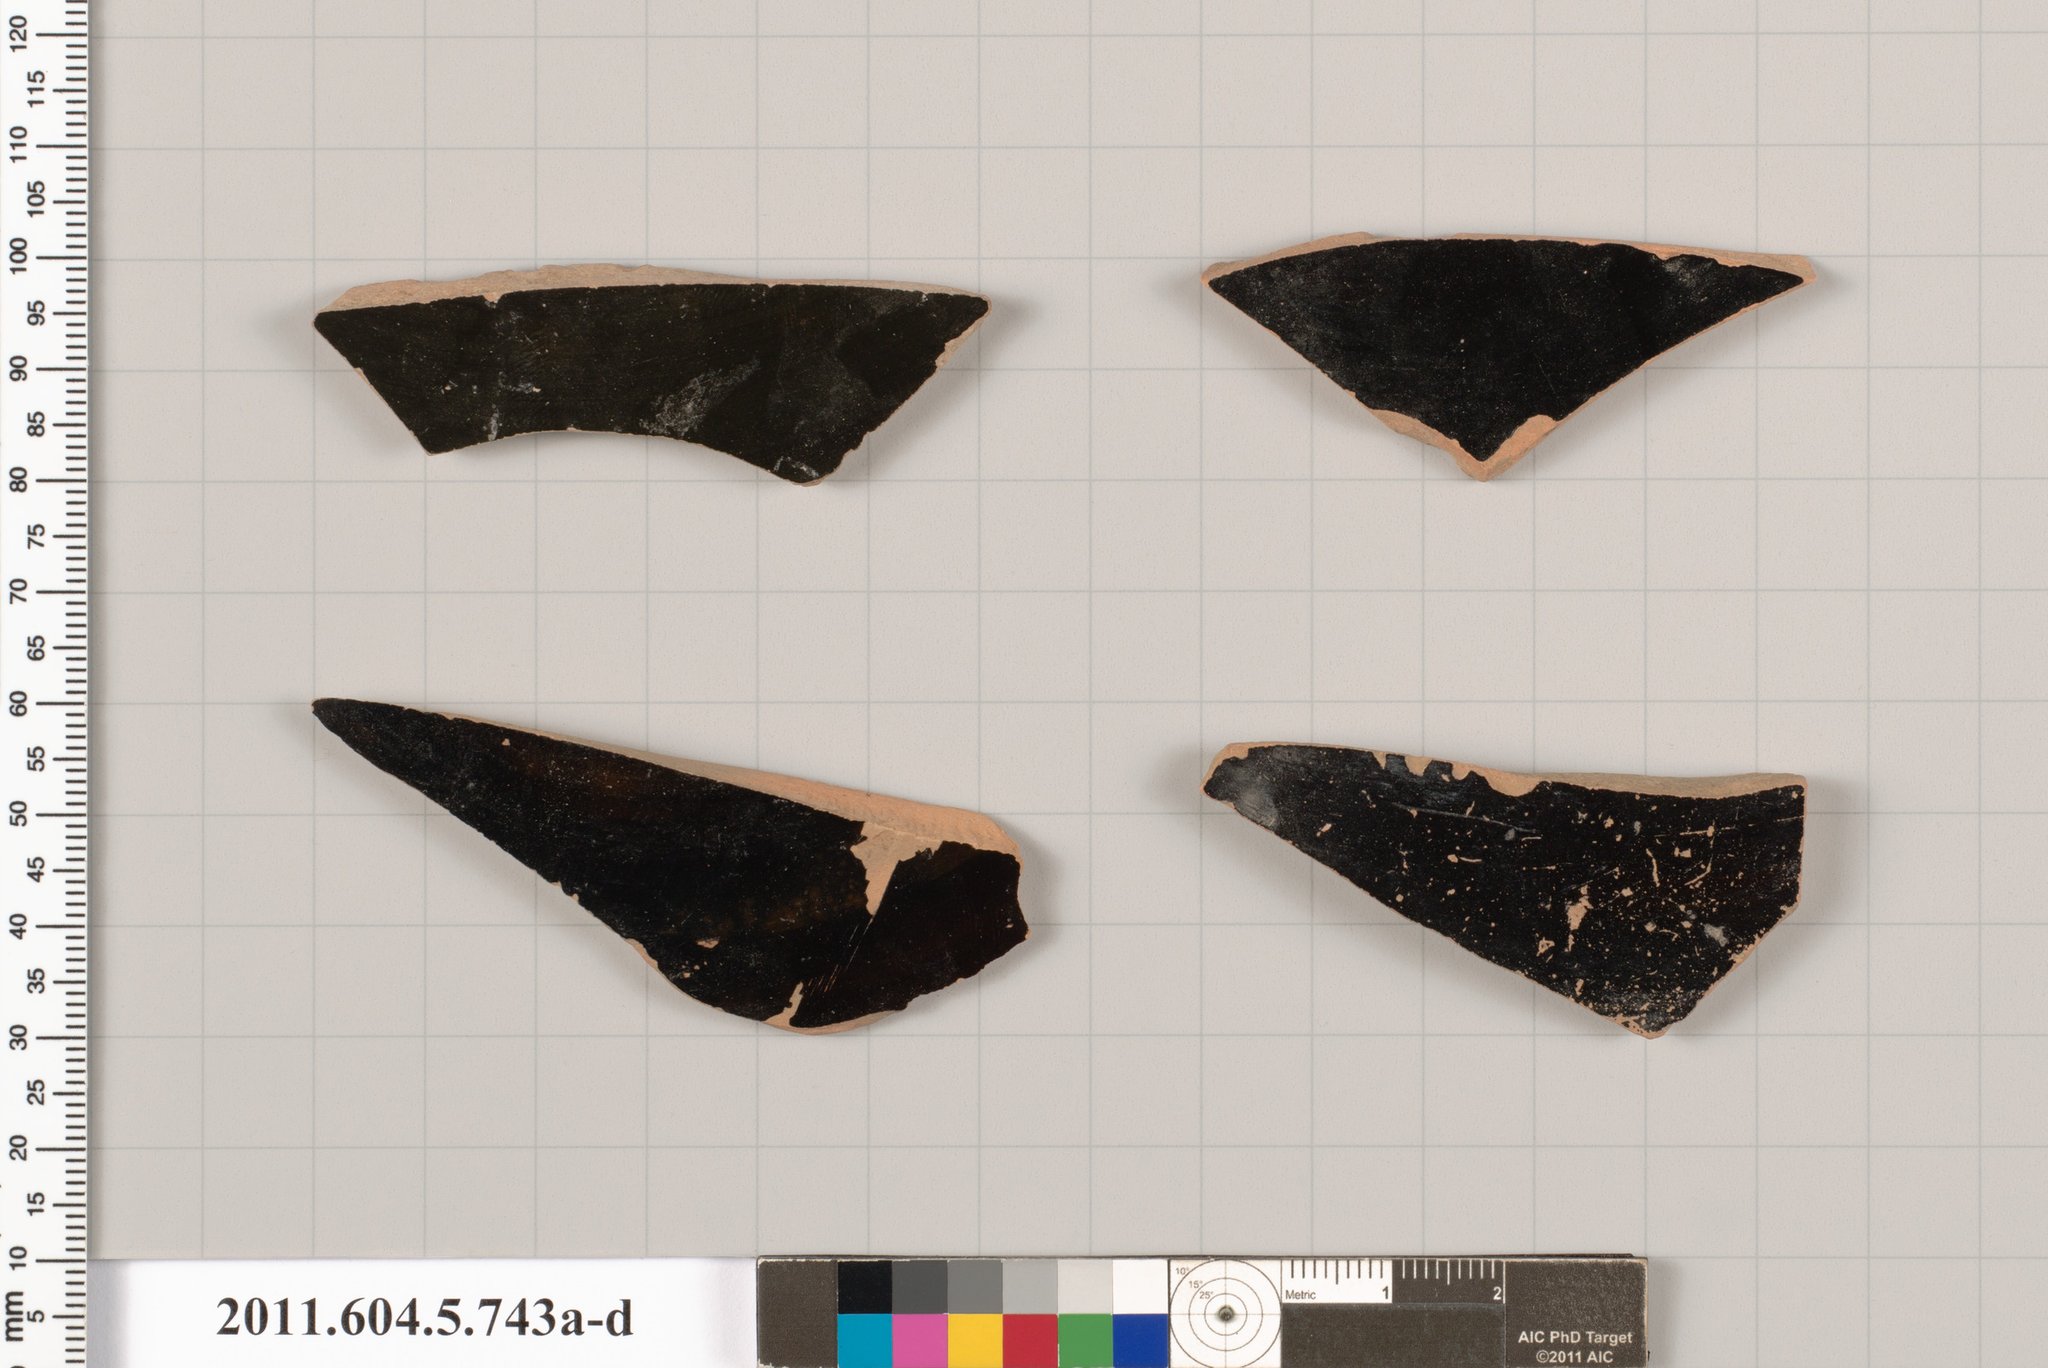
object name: kylix fragment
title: Terracotta fragments of kylikes (drinking cups)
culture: greek, attic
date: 600-401 BCE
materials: terracotta